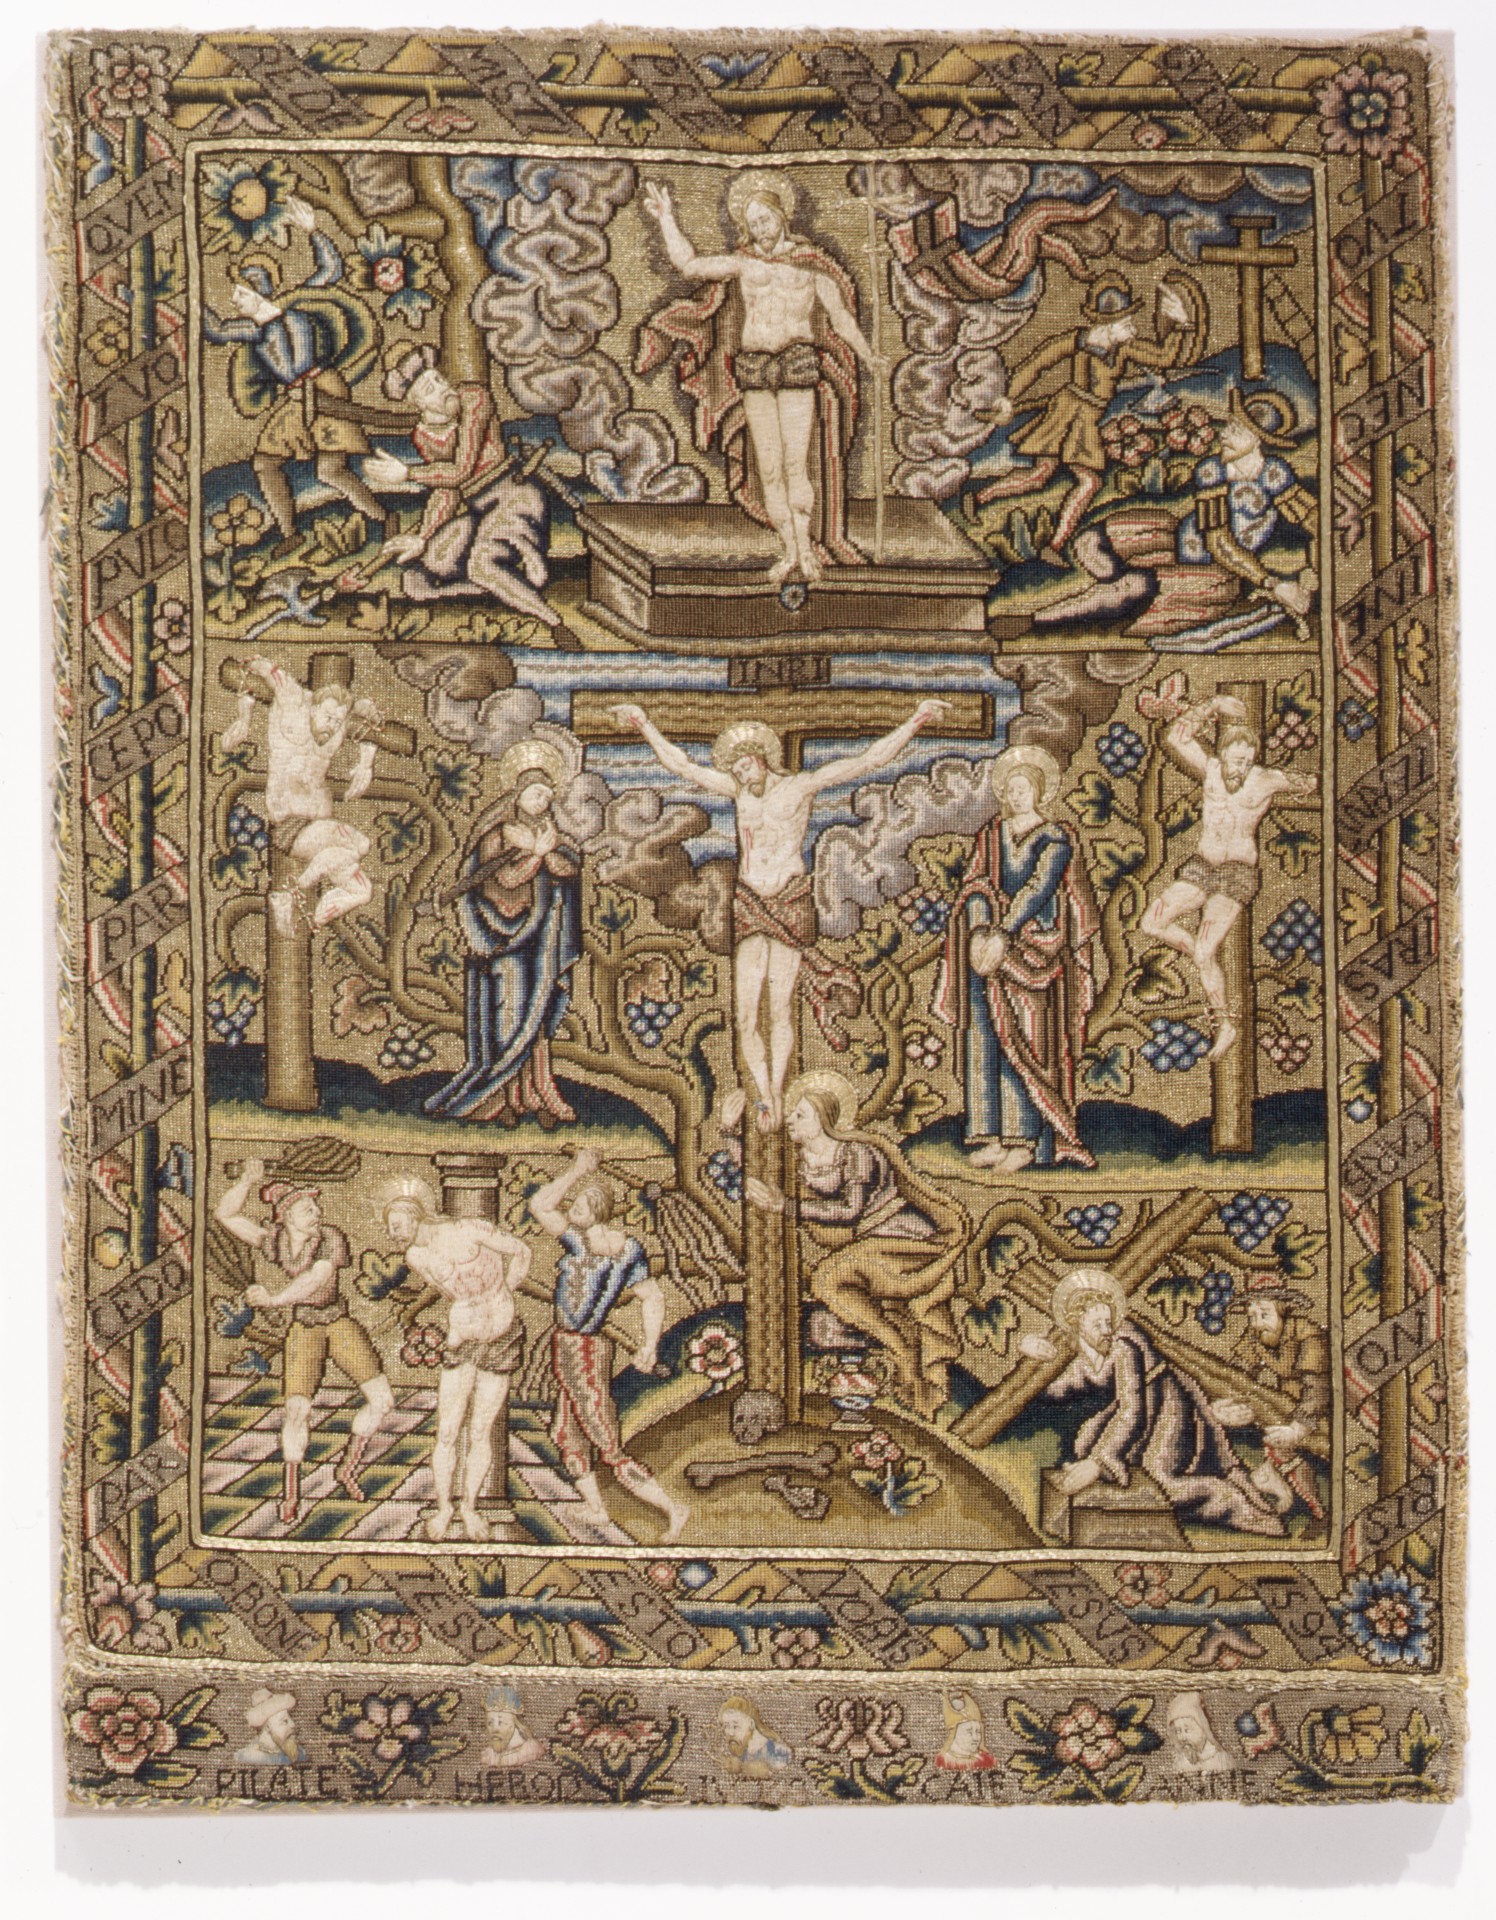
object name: embroidered picture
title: Scenes from the Passion of Christ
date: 1594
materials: canvas, metal thread, silk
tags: human figures,christ,crucifixion